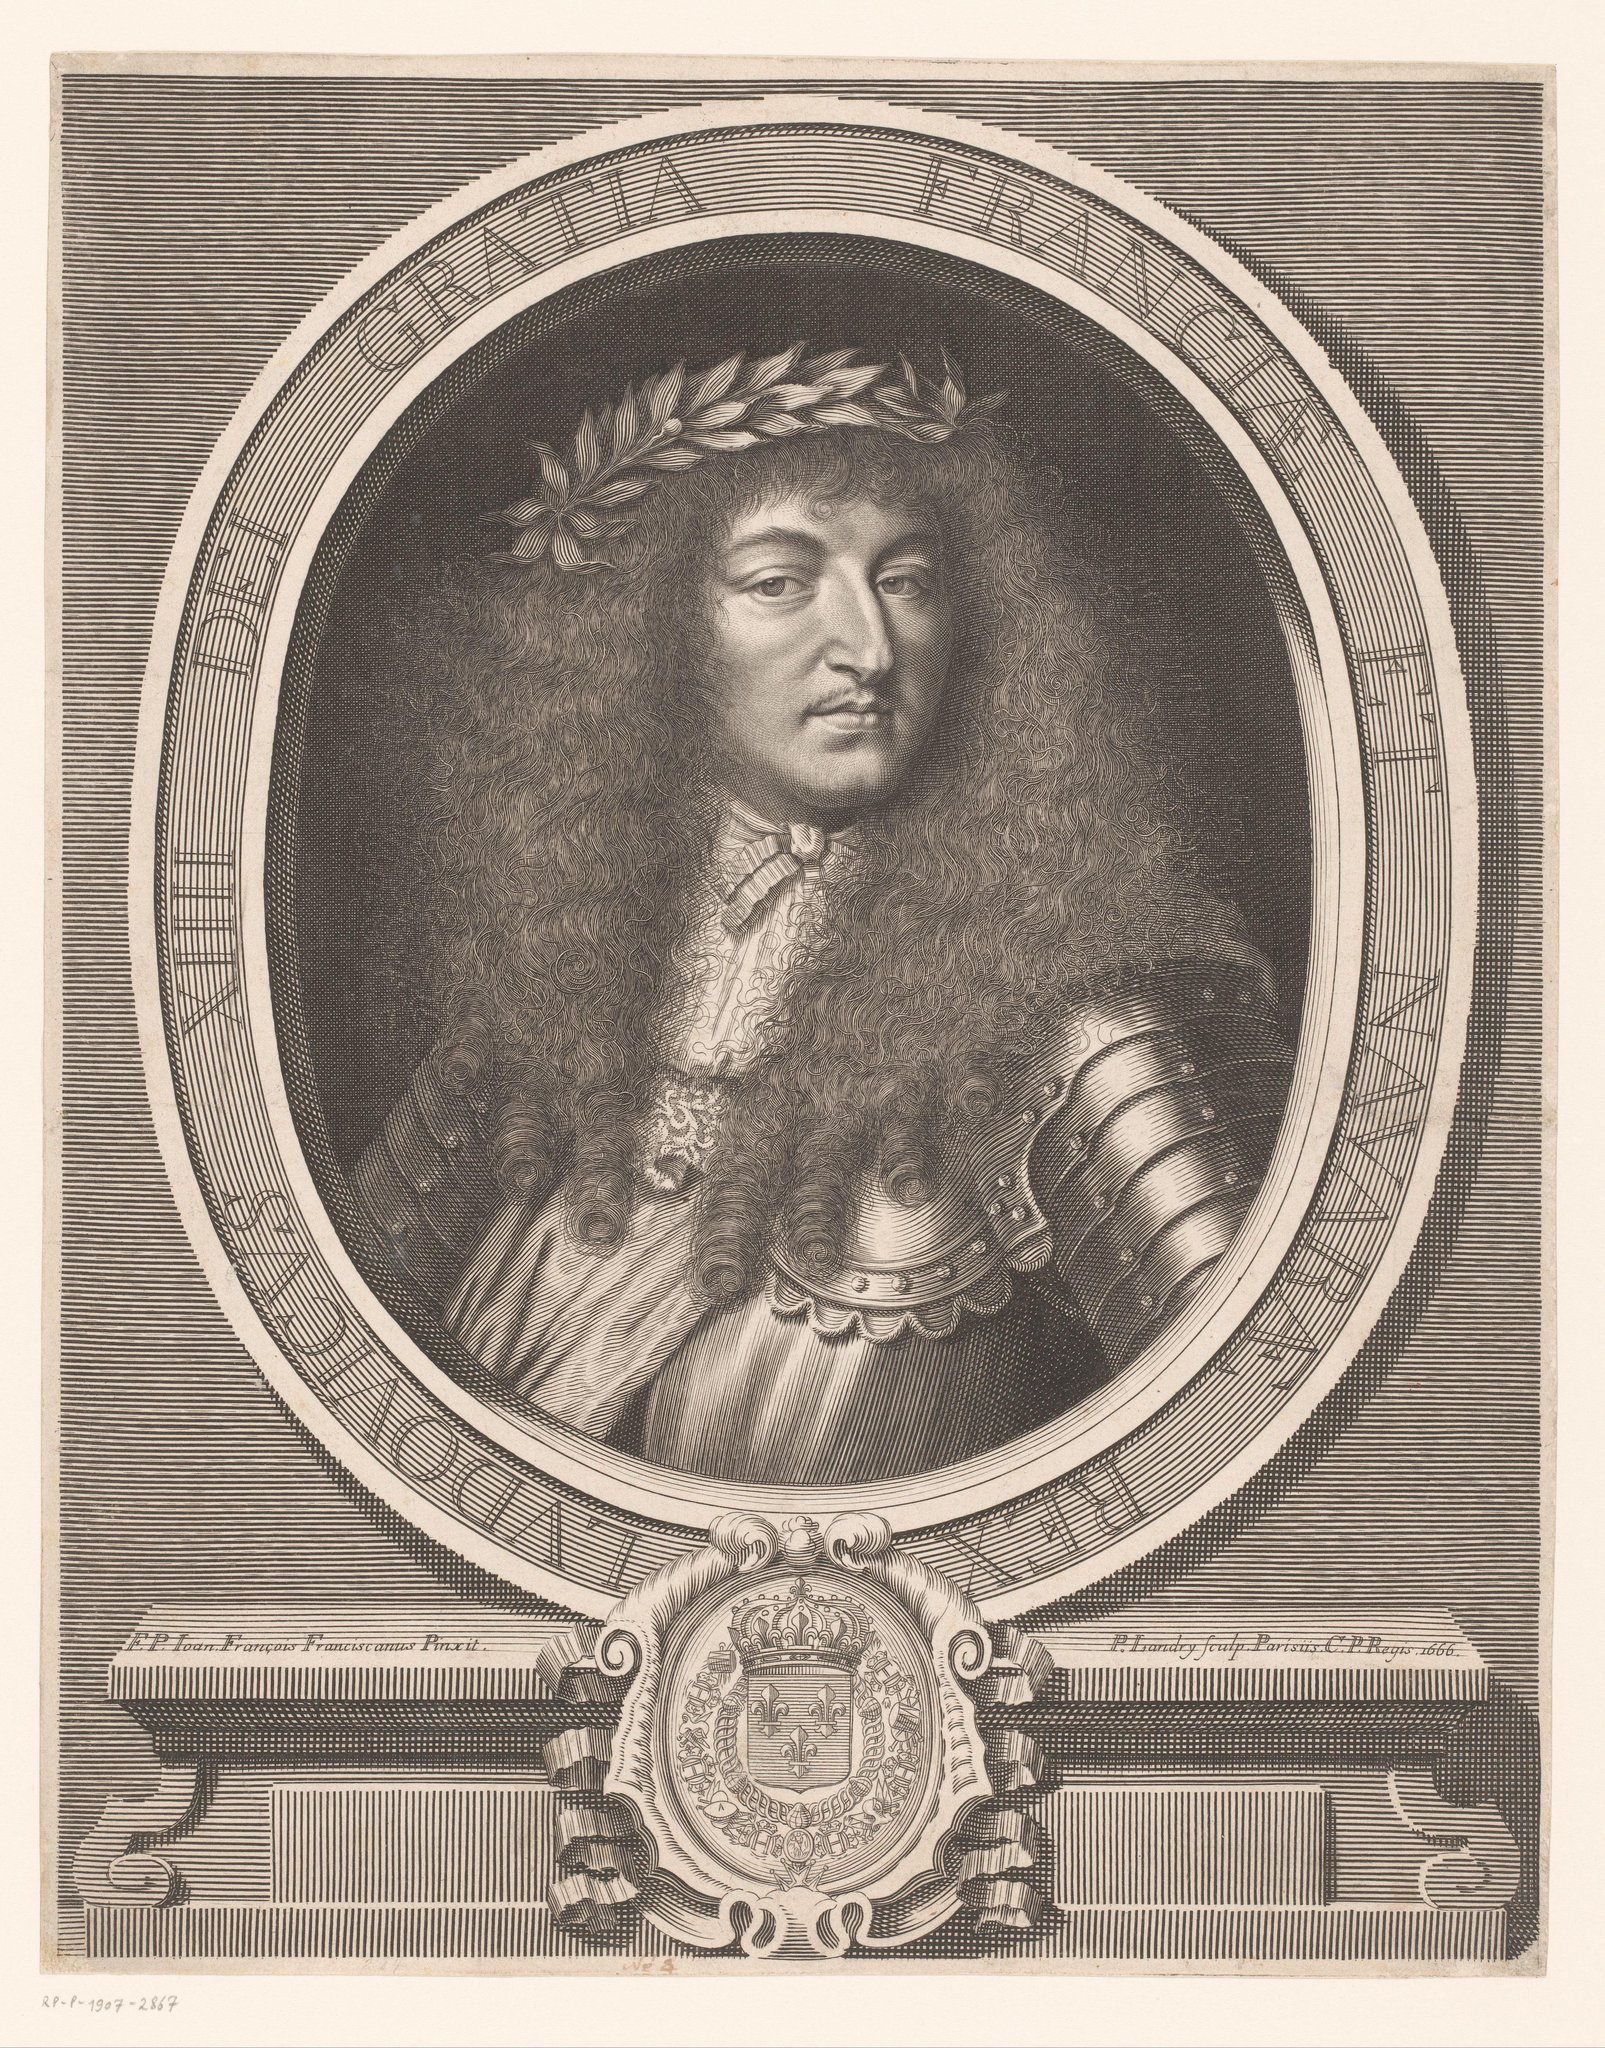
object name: print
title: Portret van Lodewijk XIV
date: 1666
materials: paper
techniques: engraving, etching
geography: paris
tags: lodewijk xiv (koning van frankrijk), historical persons, ruler, sovereign, armorial bearing, heraldry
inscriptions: collector's mark: Lugt 2228